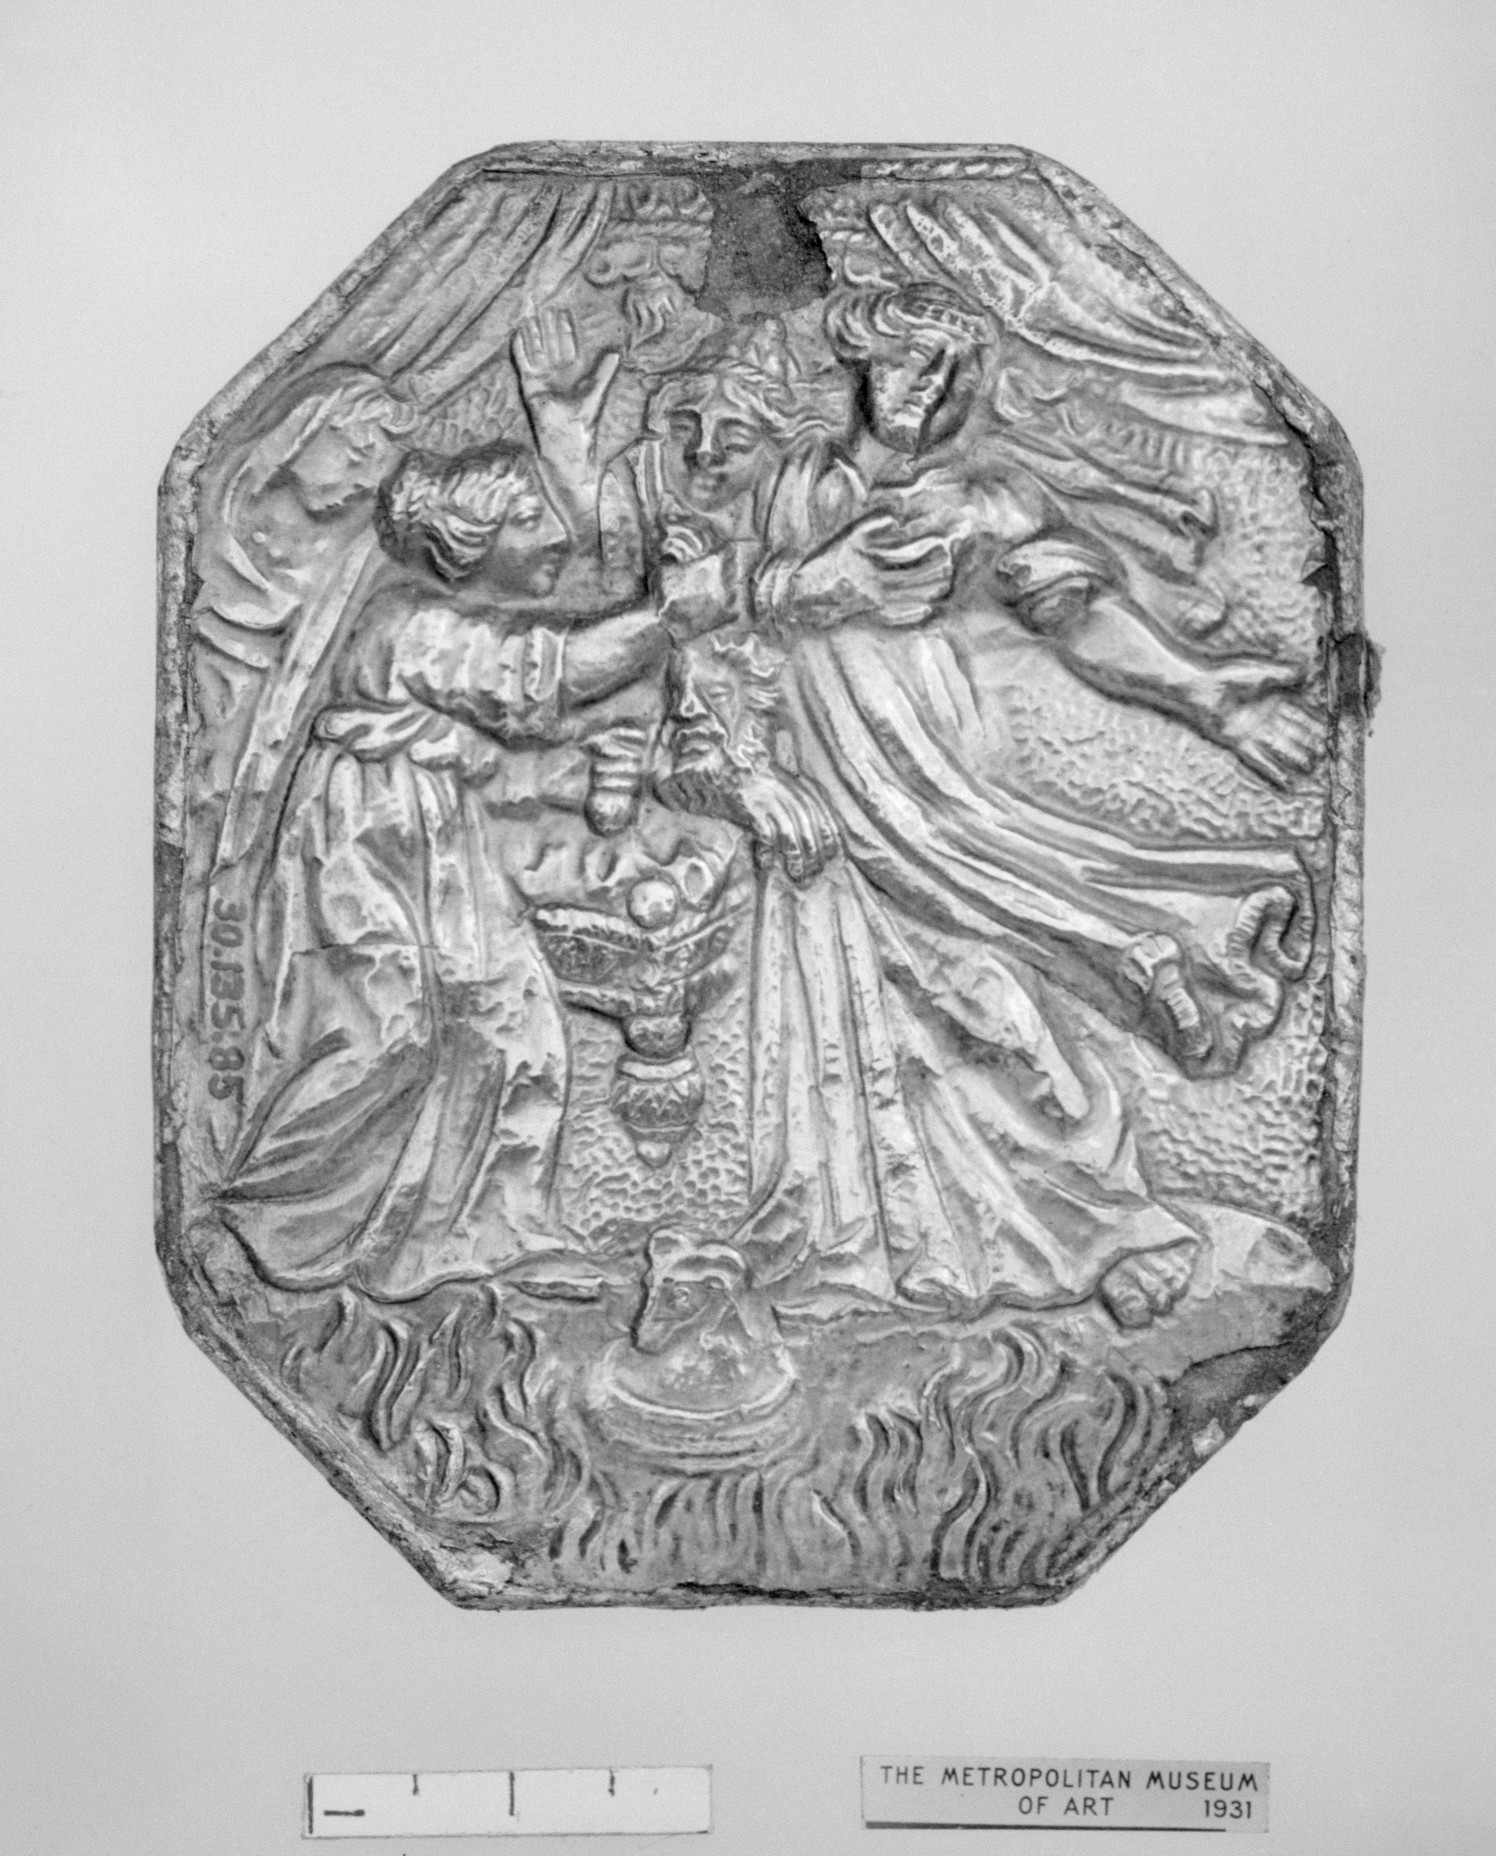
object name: mirror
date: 1650-1700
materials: silver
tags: women,mirrors